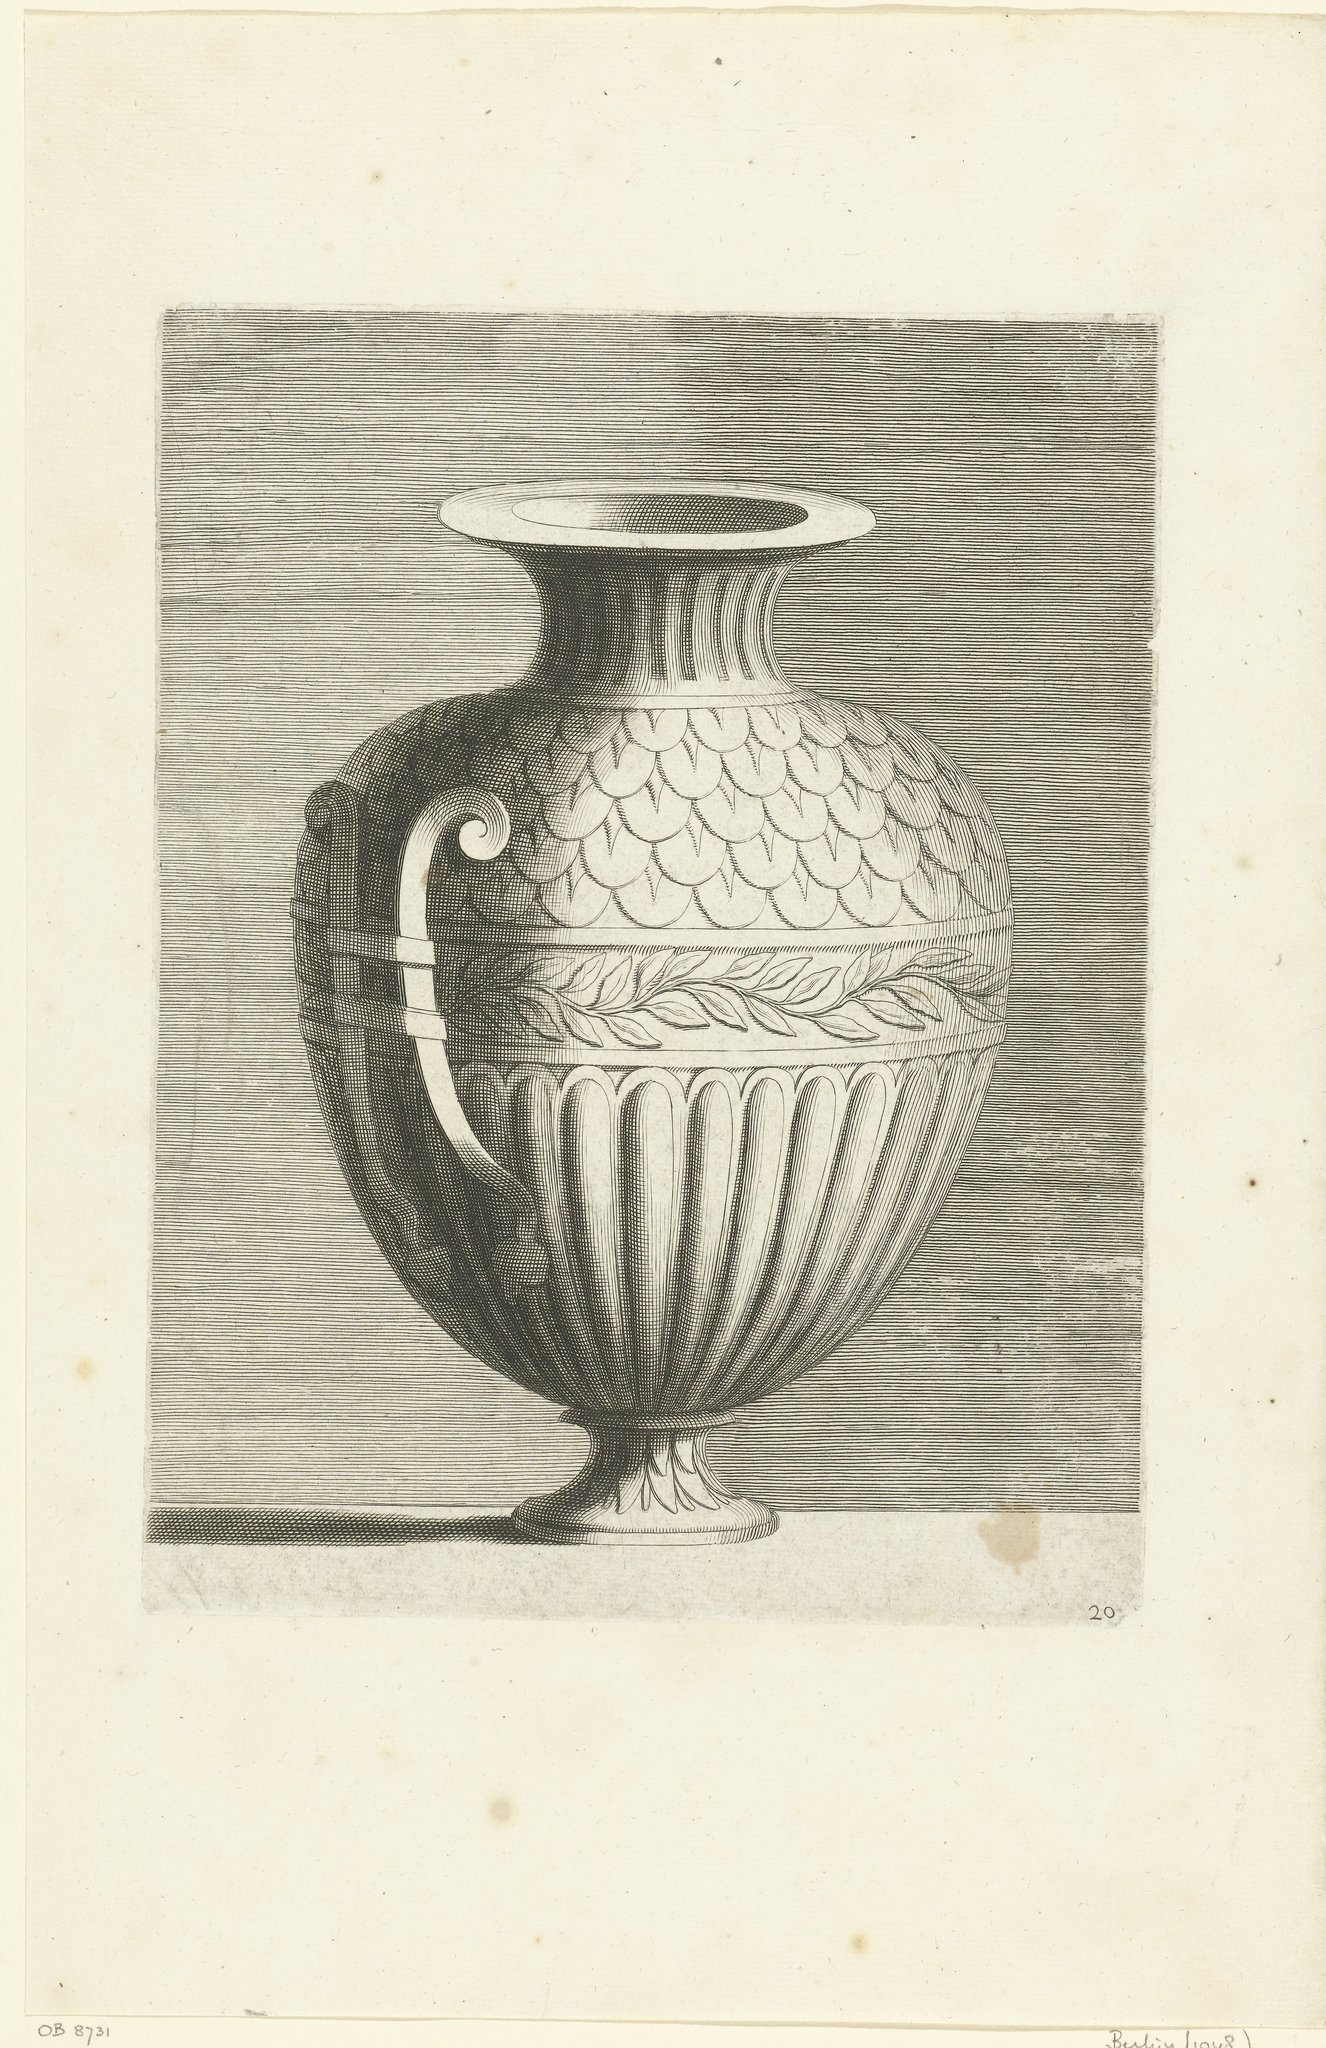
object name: ornament print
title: Vaas met schubben en lobben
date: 1657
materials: paper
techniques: engraving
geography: france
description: Blad 20 uit serie van 24 bladen, genummerd: 1-21, 23-25.